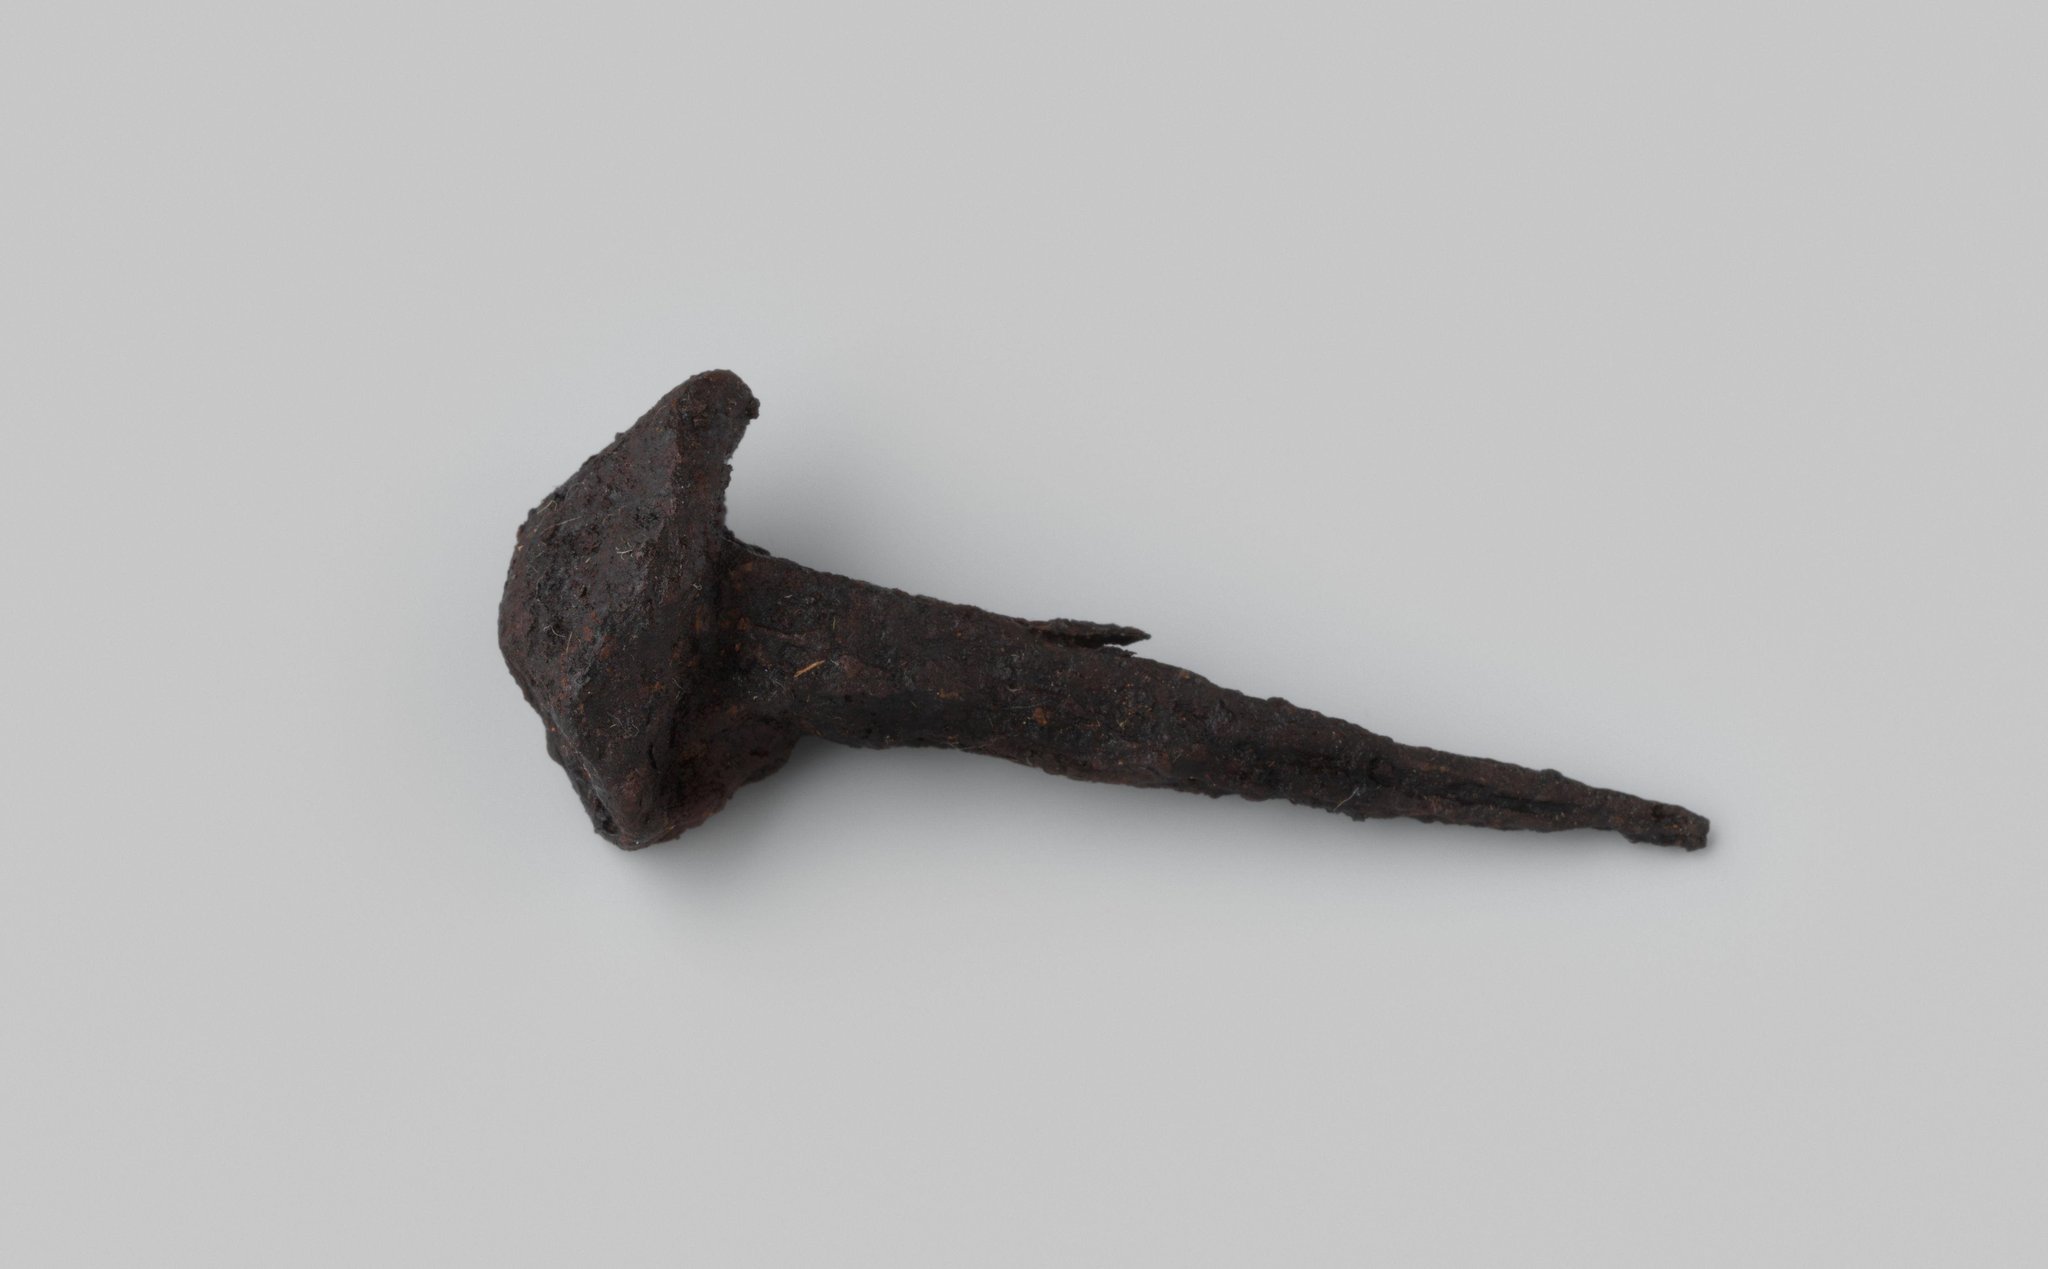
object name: nagel, spijker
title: Spijker afkomstig uit het wrak van de Oost-Indiëvaarder Hollandia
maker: Anonymous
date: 1700-1743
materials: iron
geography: netherlands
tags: verenigde oostindische compagnie, hollandia (schip)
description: Nails; sim. 79-27H, large four faceted head.